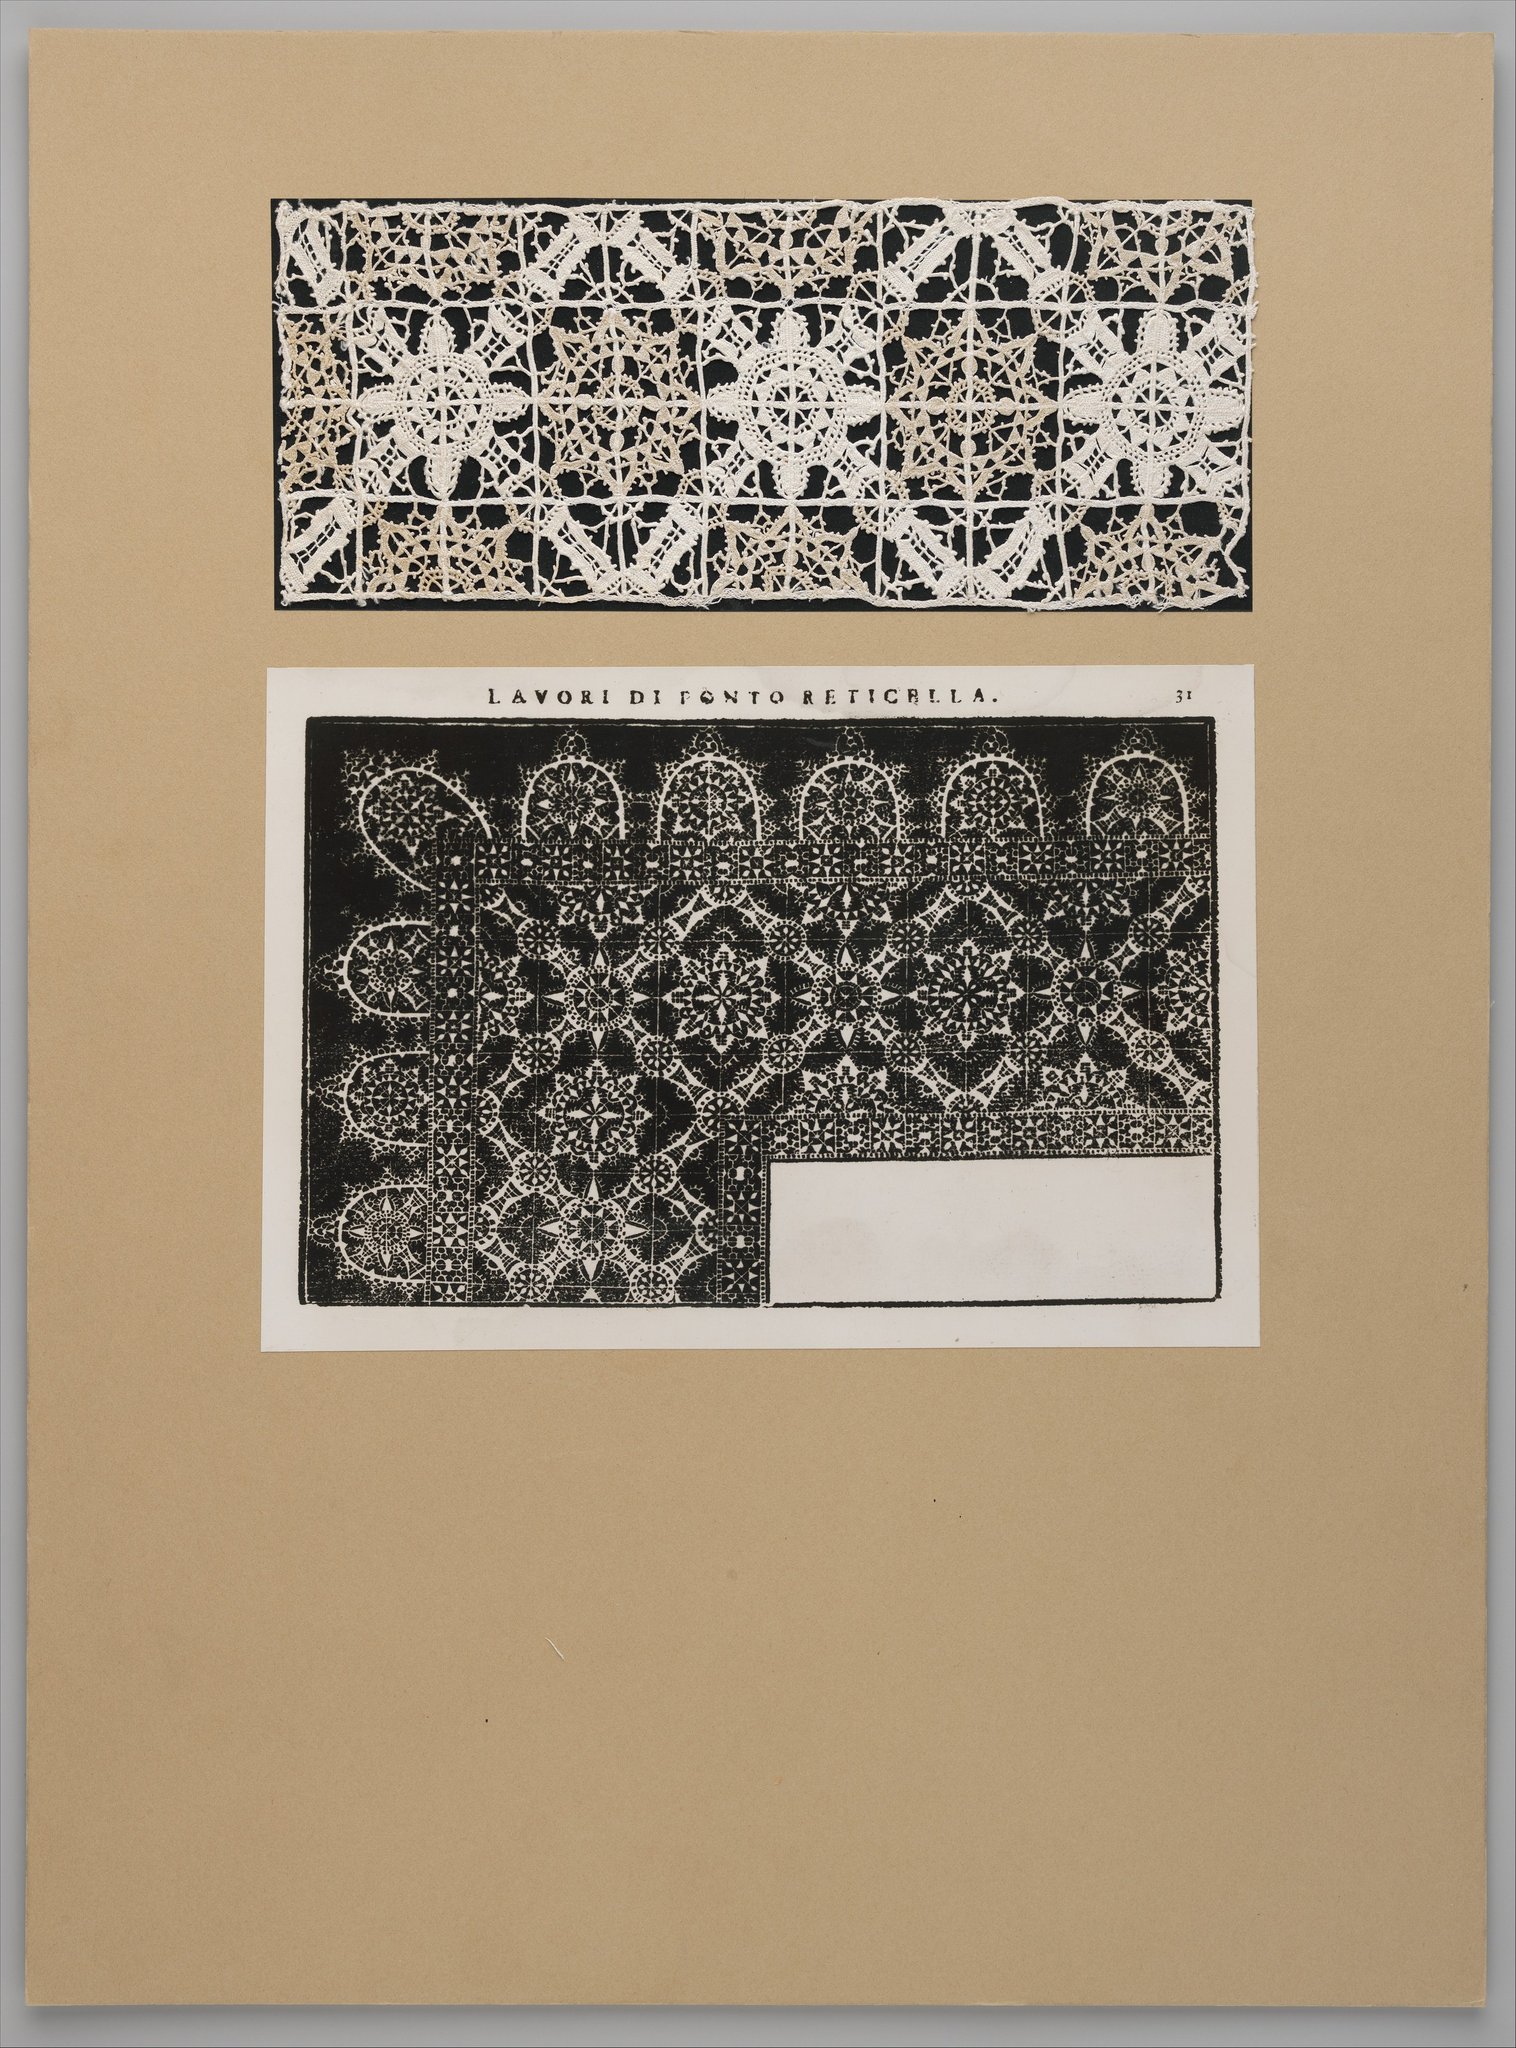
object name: piece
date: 1601-1633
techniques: lace